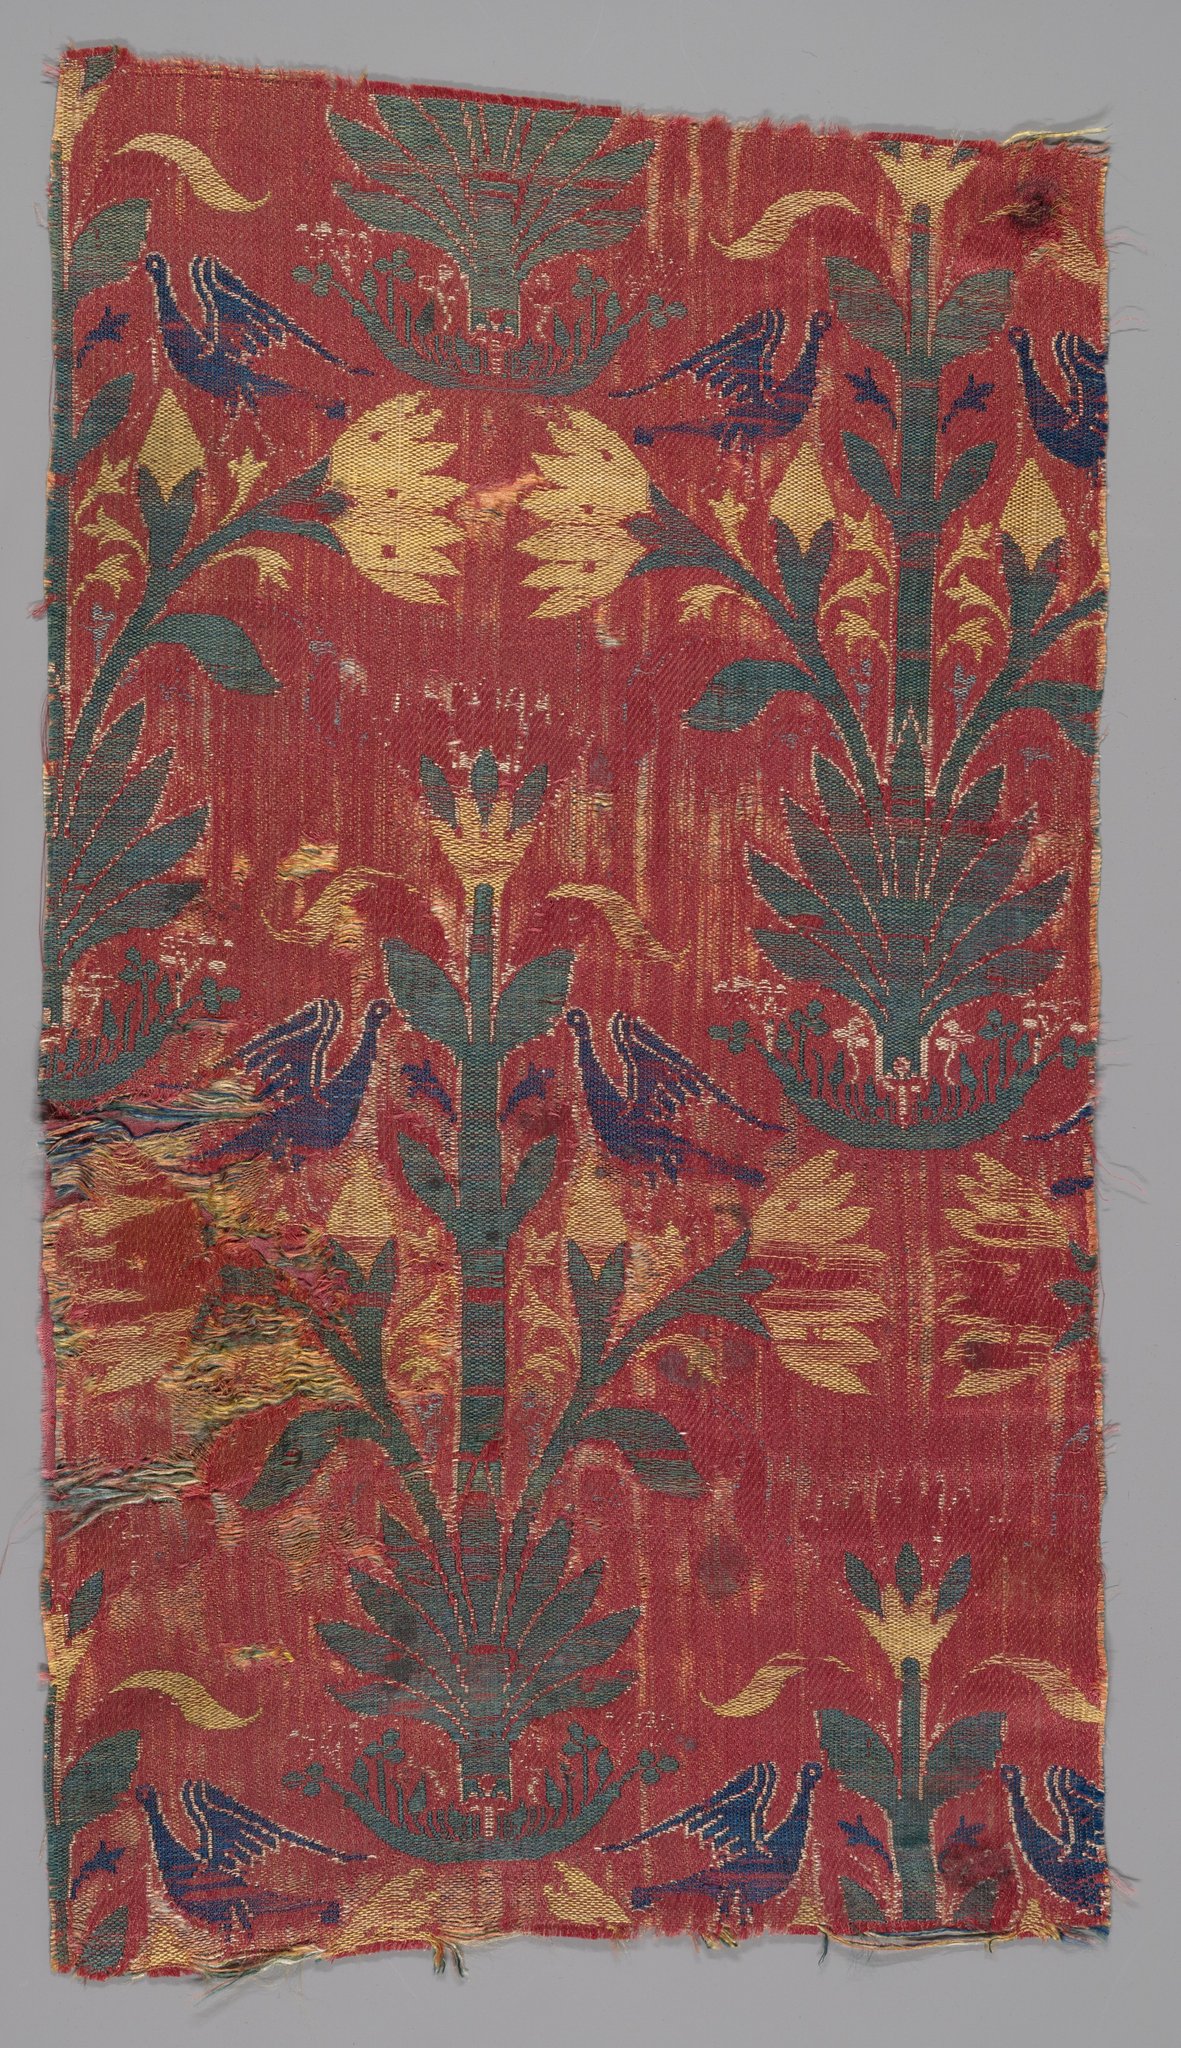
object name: textile fragment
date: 1401-1500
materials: silk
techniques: lampas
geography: spain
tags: birds,flowers